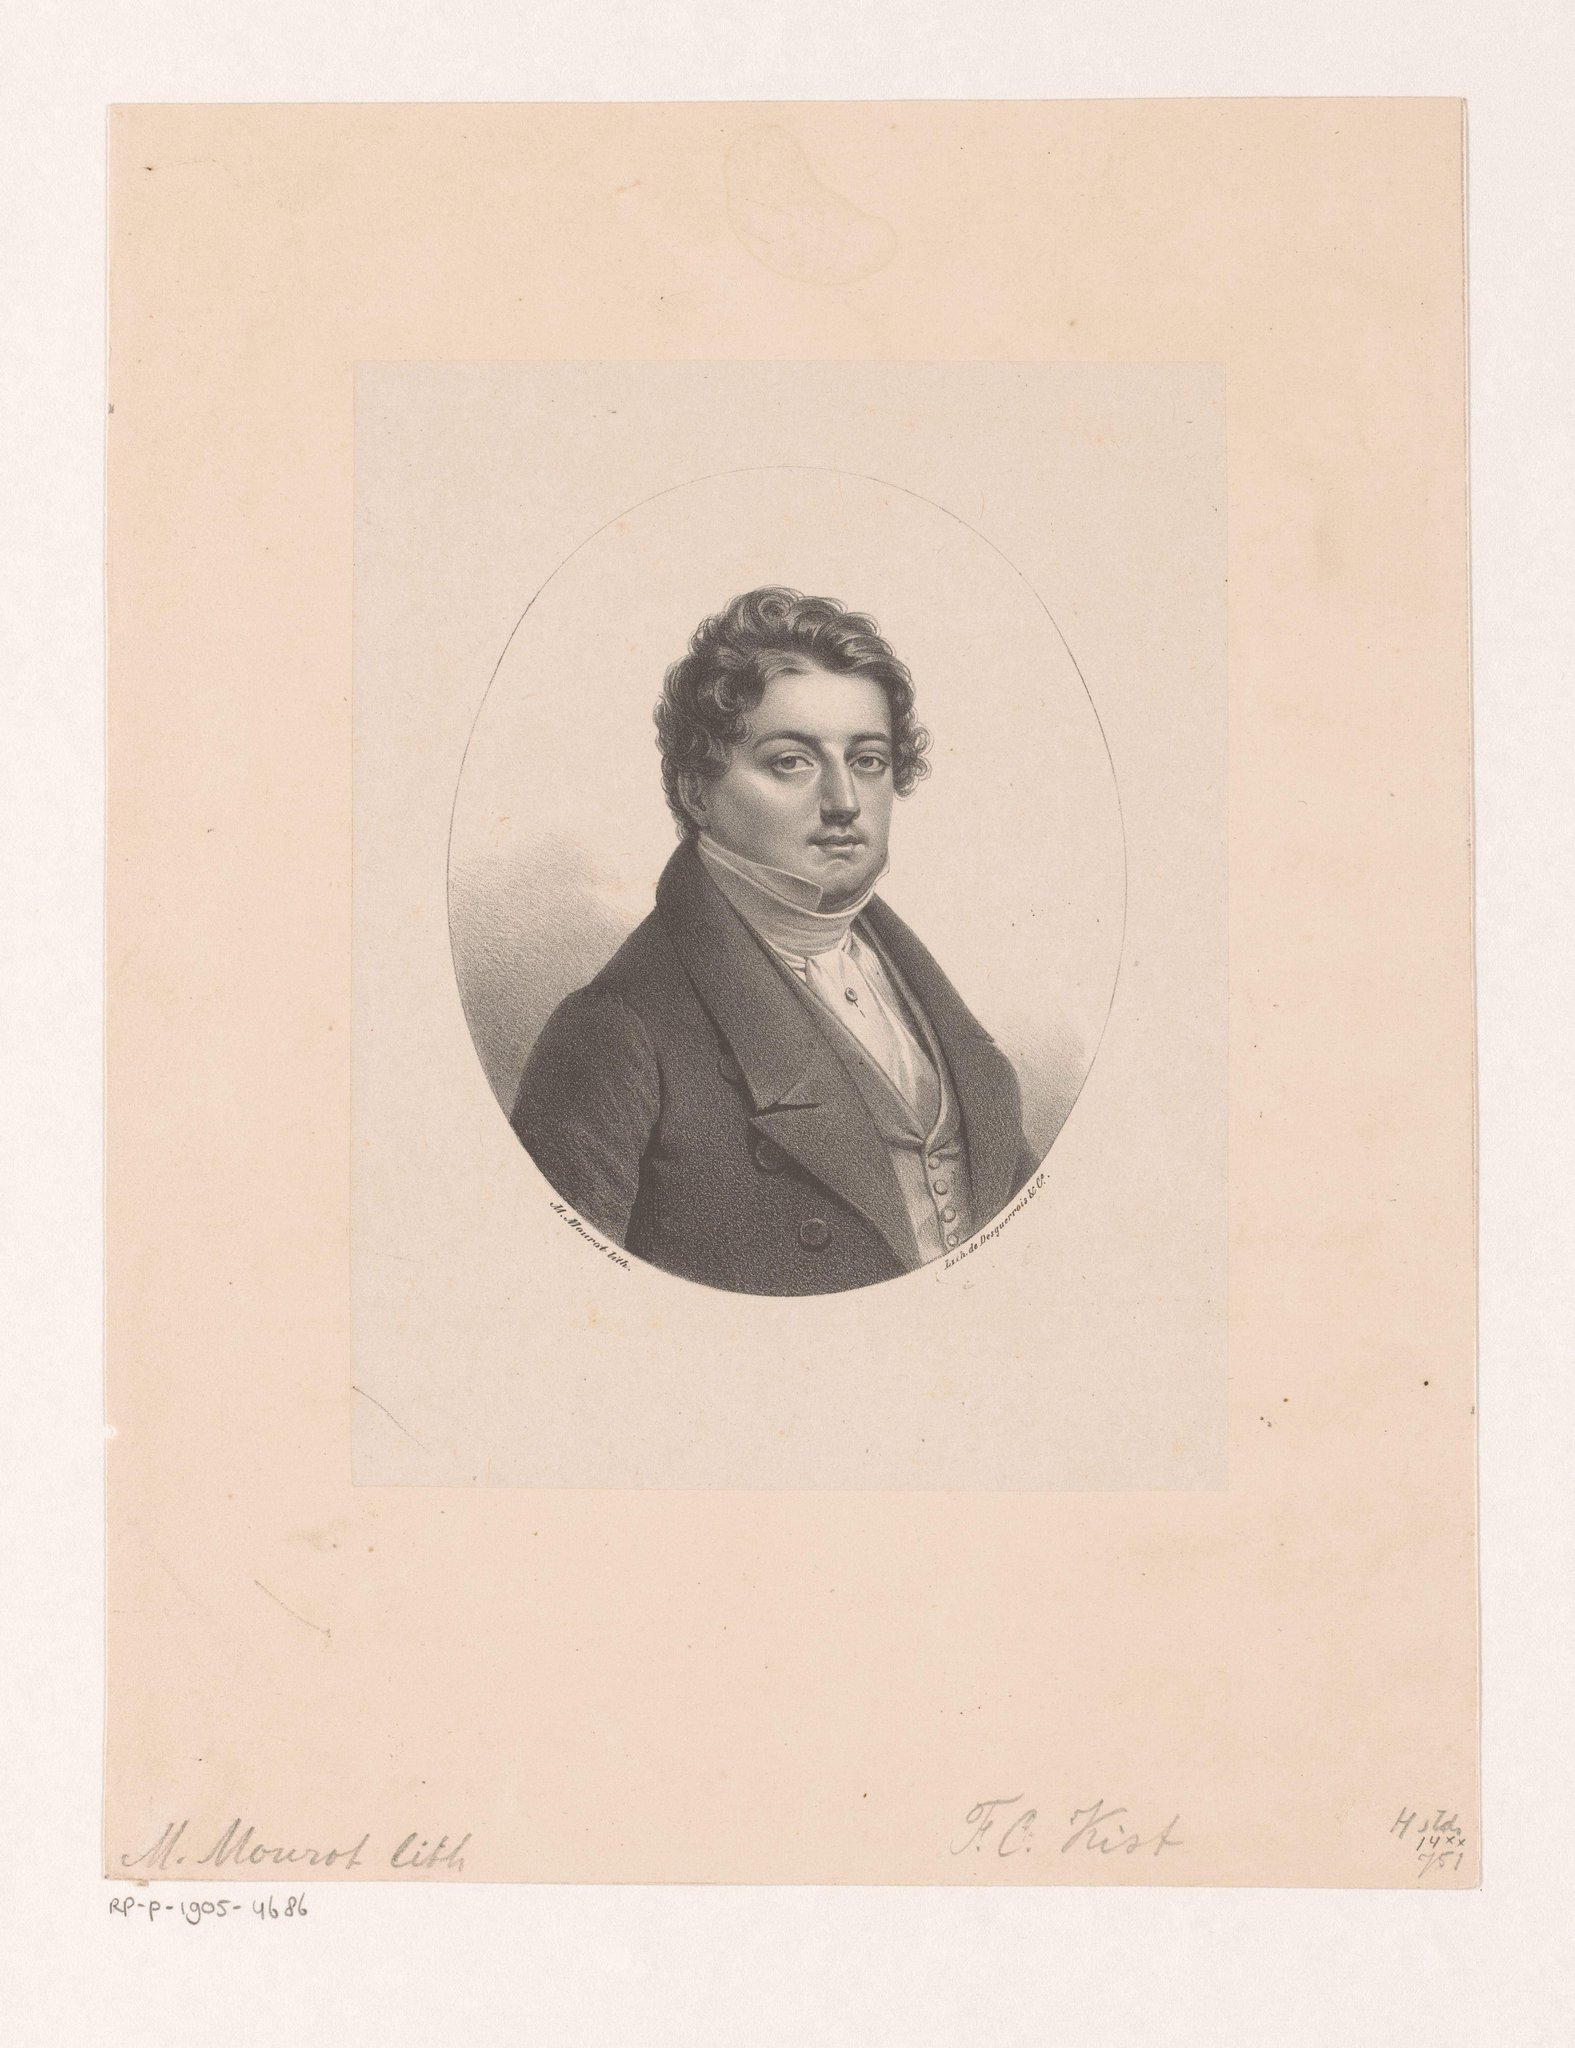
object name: print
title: Portret van Florentius Cornelis Kist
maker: michel mourot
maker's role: draughtsman, print maker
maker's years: 1803-1847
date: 1813-1847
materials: paper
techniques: lithograph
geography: amsterdam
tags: arnhem, the hague, historical persons (+ (full) bust portrait)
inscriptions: collector's mark: Lugt 2228